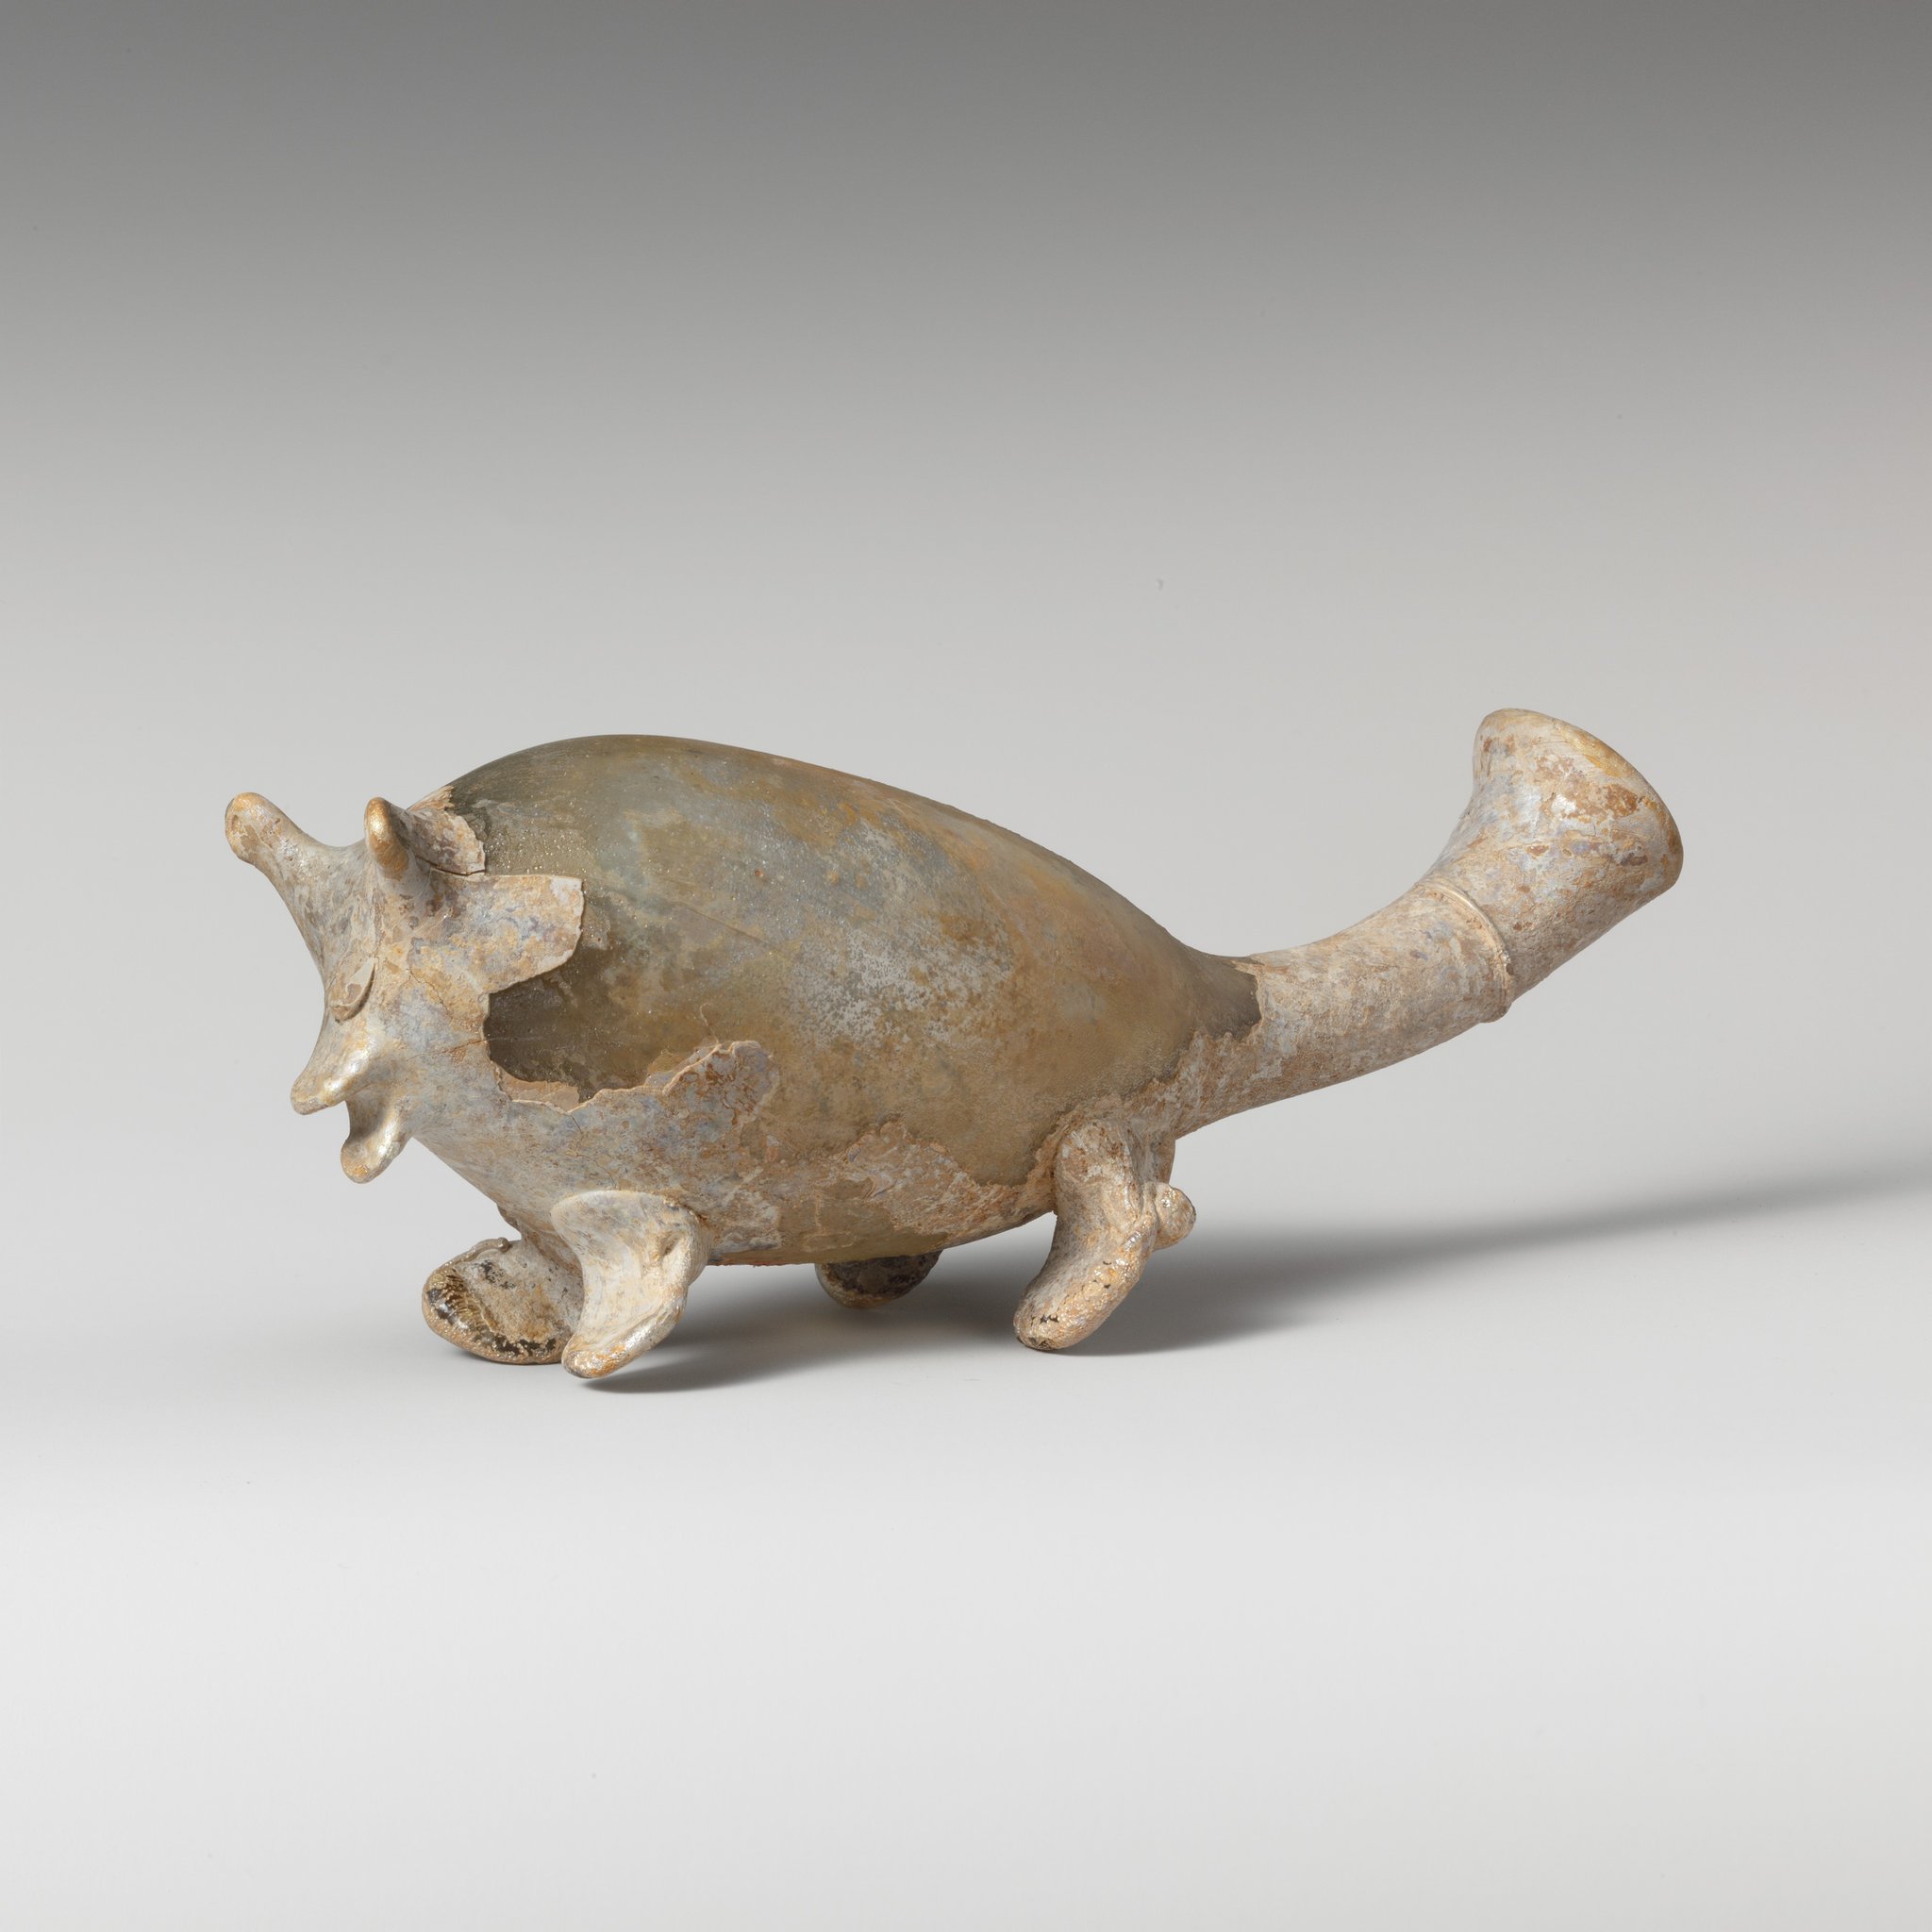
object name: bottle in the form of an animal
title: Glass bottle in the shape of an animal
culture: roman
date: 201-300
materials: glass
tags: animals